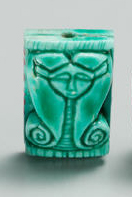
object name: seal, hathor, inscribed to amenhotep i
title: Hathor emblem seal inscribed to Amenhotep I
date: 1479-1458 BCE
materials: stone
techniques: glazing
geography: egypt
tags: hathor